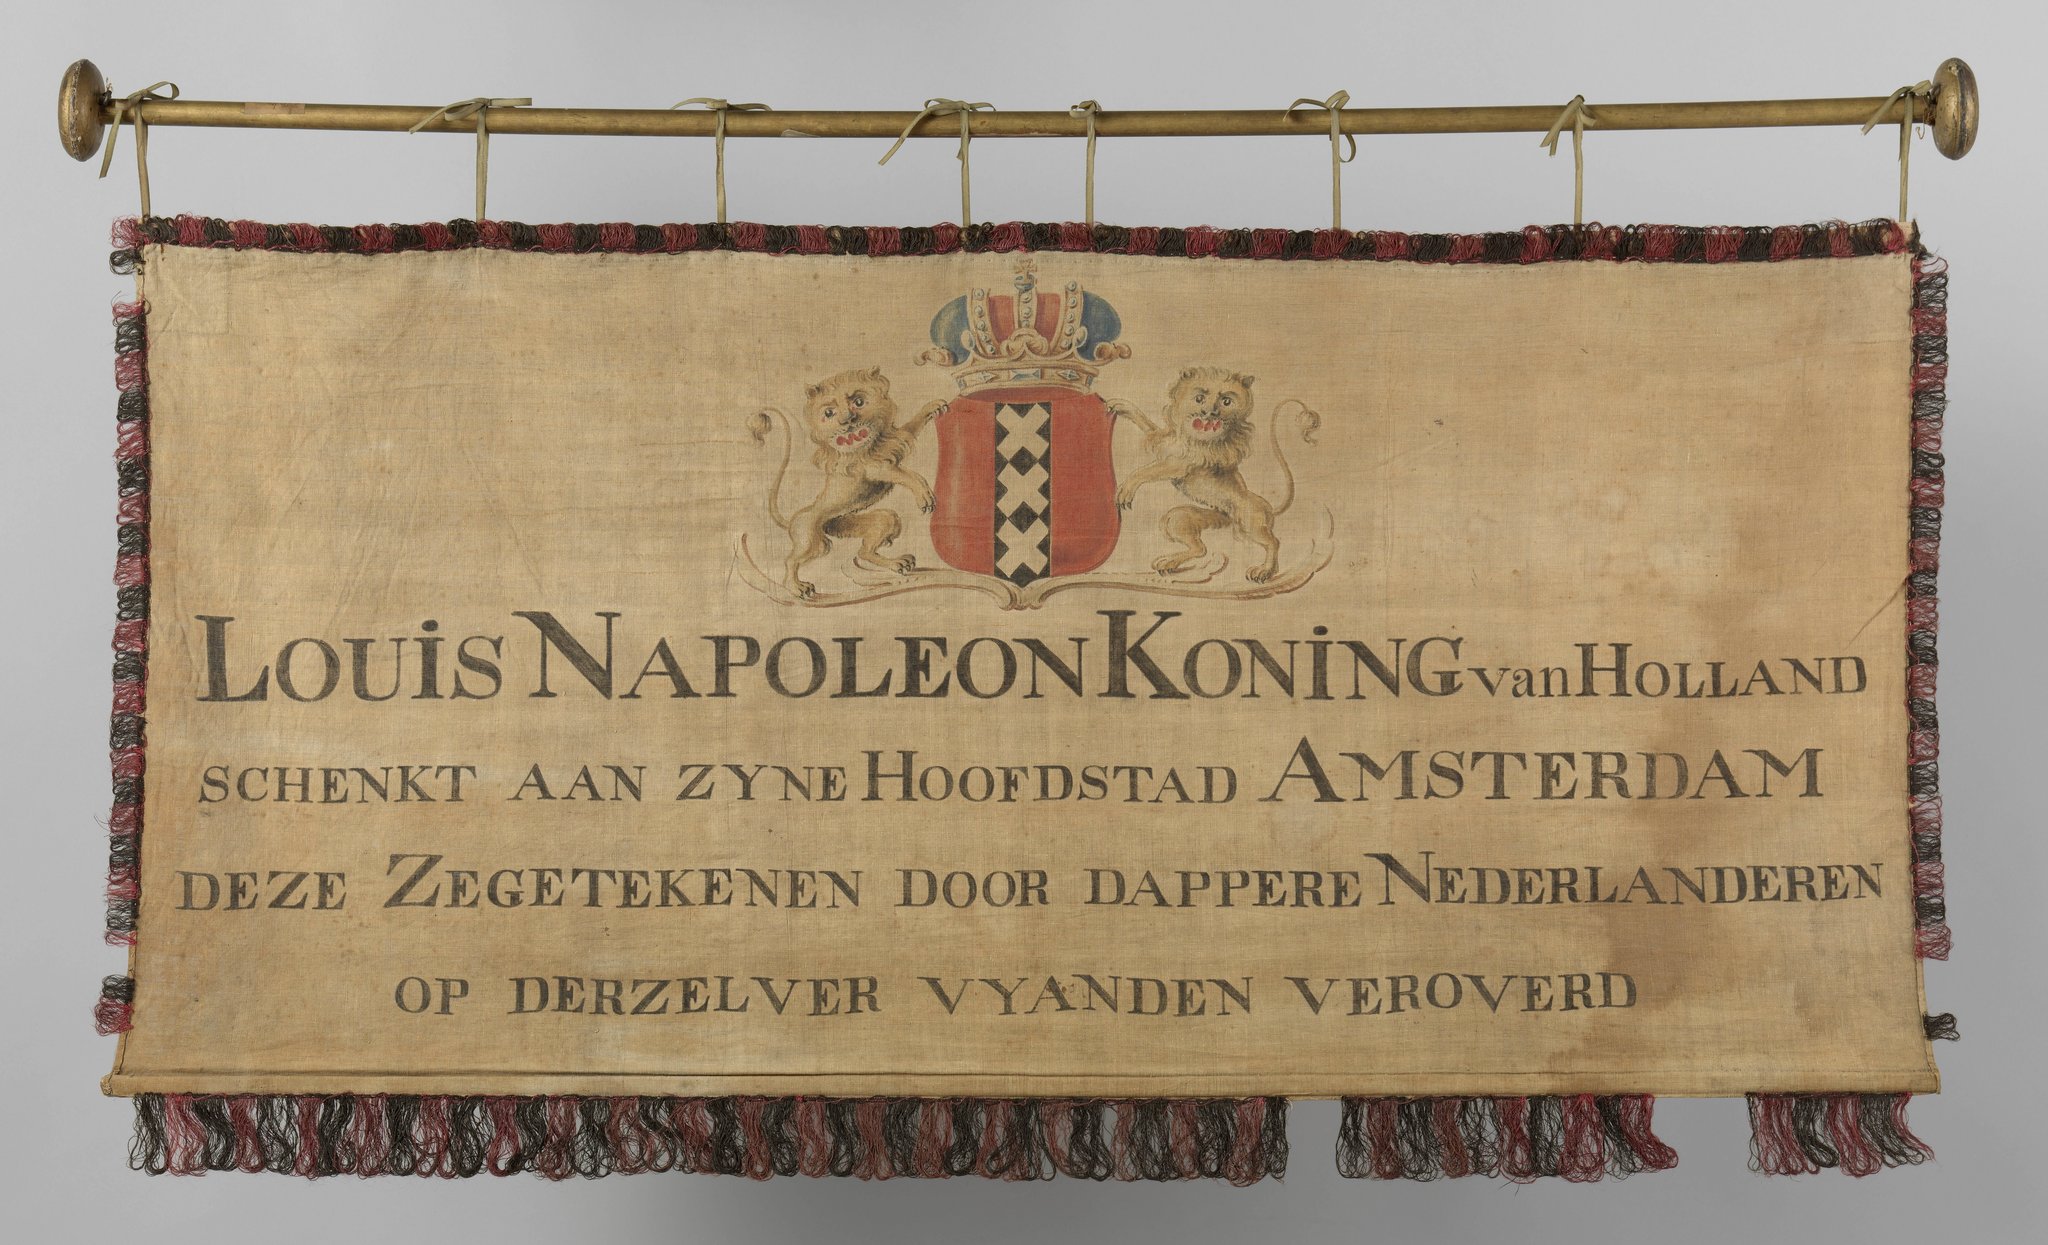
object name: banner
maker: Anonymous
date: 1806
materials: paint, wood, wool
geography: amsterdam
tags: louis napoleon (king of holland), amsterdam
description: Louis Napoleon made Amsterdam the capital of his kingdom and assembled national treasures there. On 31 July 1806 he had important trophies, including captured flags, transported to Amsterdam from the Binnenhof (Dutch Parliament building) in The Hague. The convoy was headed by this banner, whose text translates as: ‘Louis Napoleon, King of Holland, presents to his capital Amsterdam these trophies seized by brave Netherlanders from their enemies’.